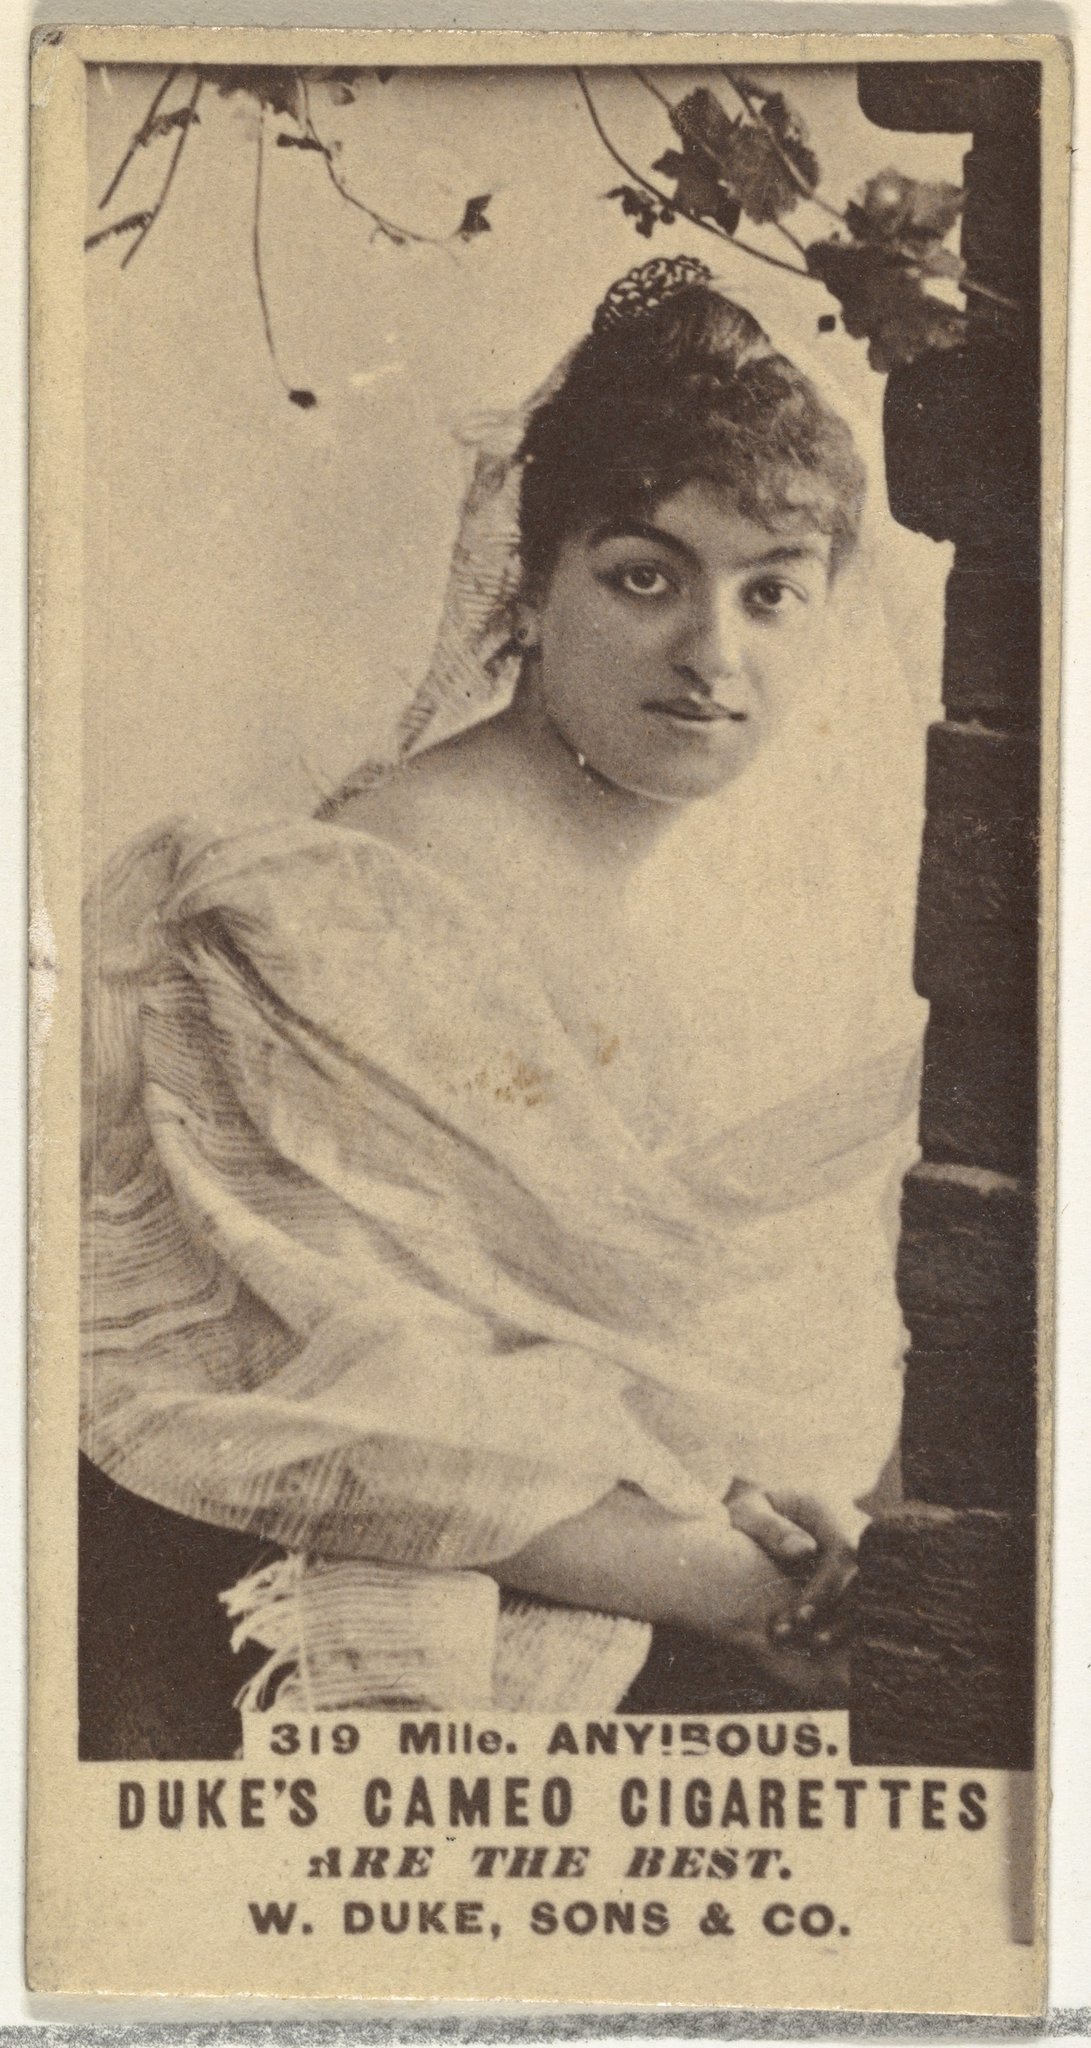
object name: photograph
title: Card Number 319, Mlle. Anyibous, from the Actors and Actresses series (N145-5) issued by Duke Sons & Co. to promote Cameo Cigarettes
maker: w. duke, sons & co.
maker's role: publisher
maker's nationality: american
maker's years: 1870-1920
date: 1880-1889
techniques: albumen silver print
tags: portraits,women,actresses